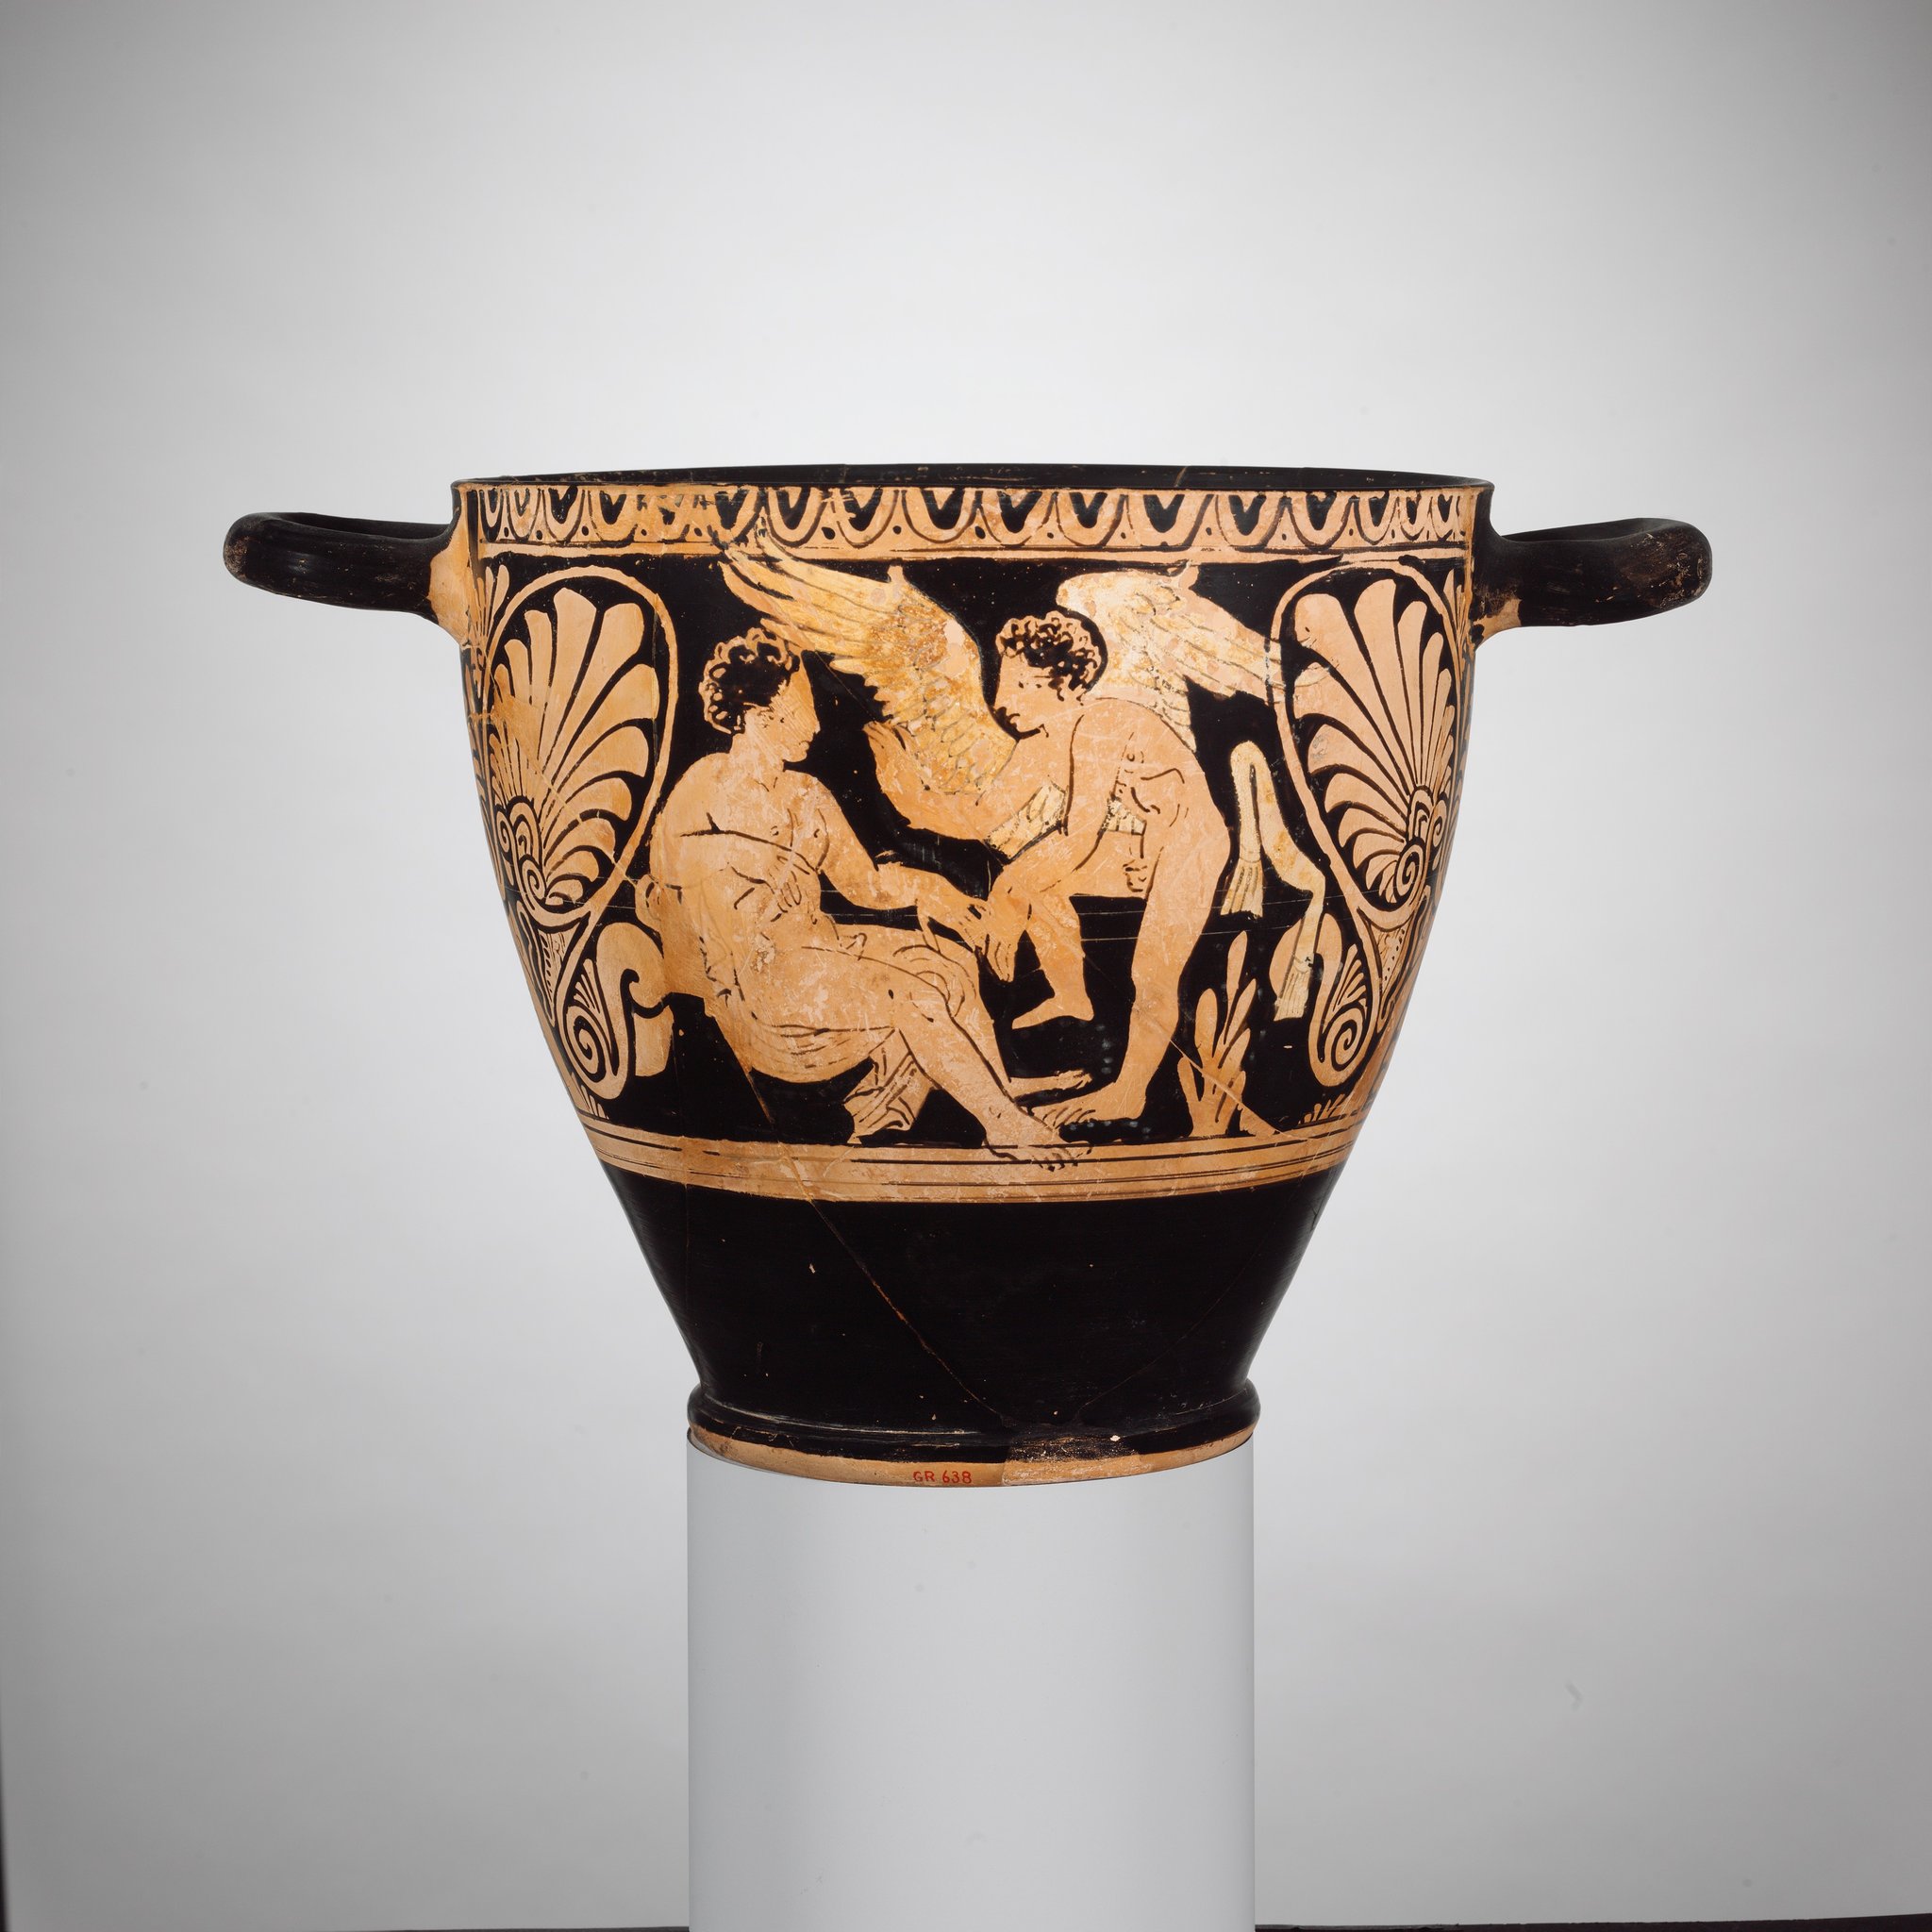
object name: skyphos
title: Terracotta skyphos (deep drinking cup)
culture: etruscan or faliscan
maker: painter of the villa giulia 1664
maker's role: artist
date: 367-335 BCE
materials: terracotta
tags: eros